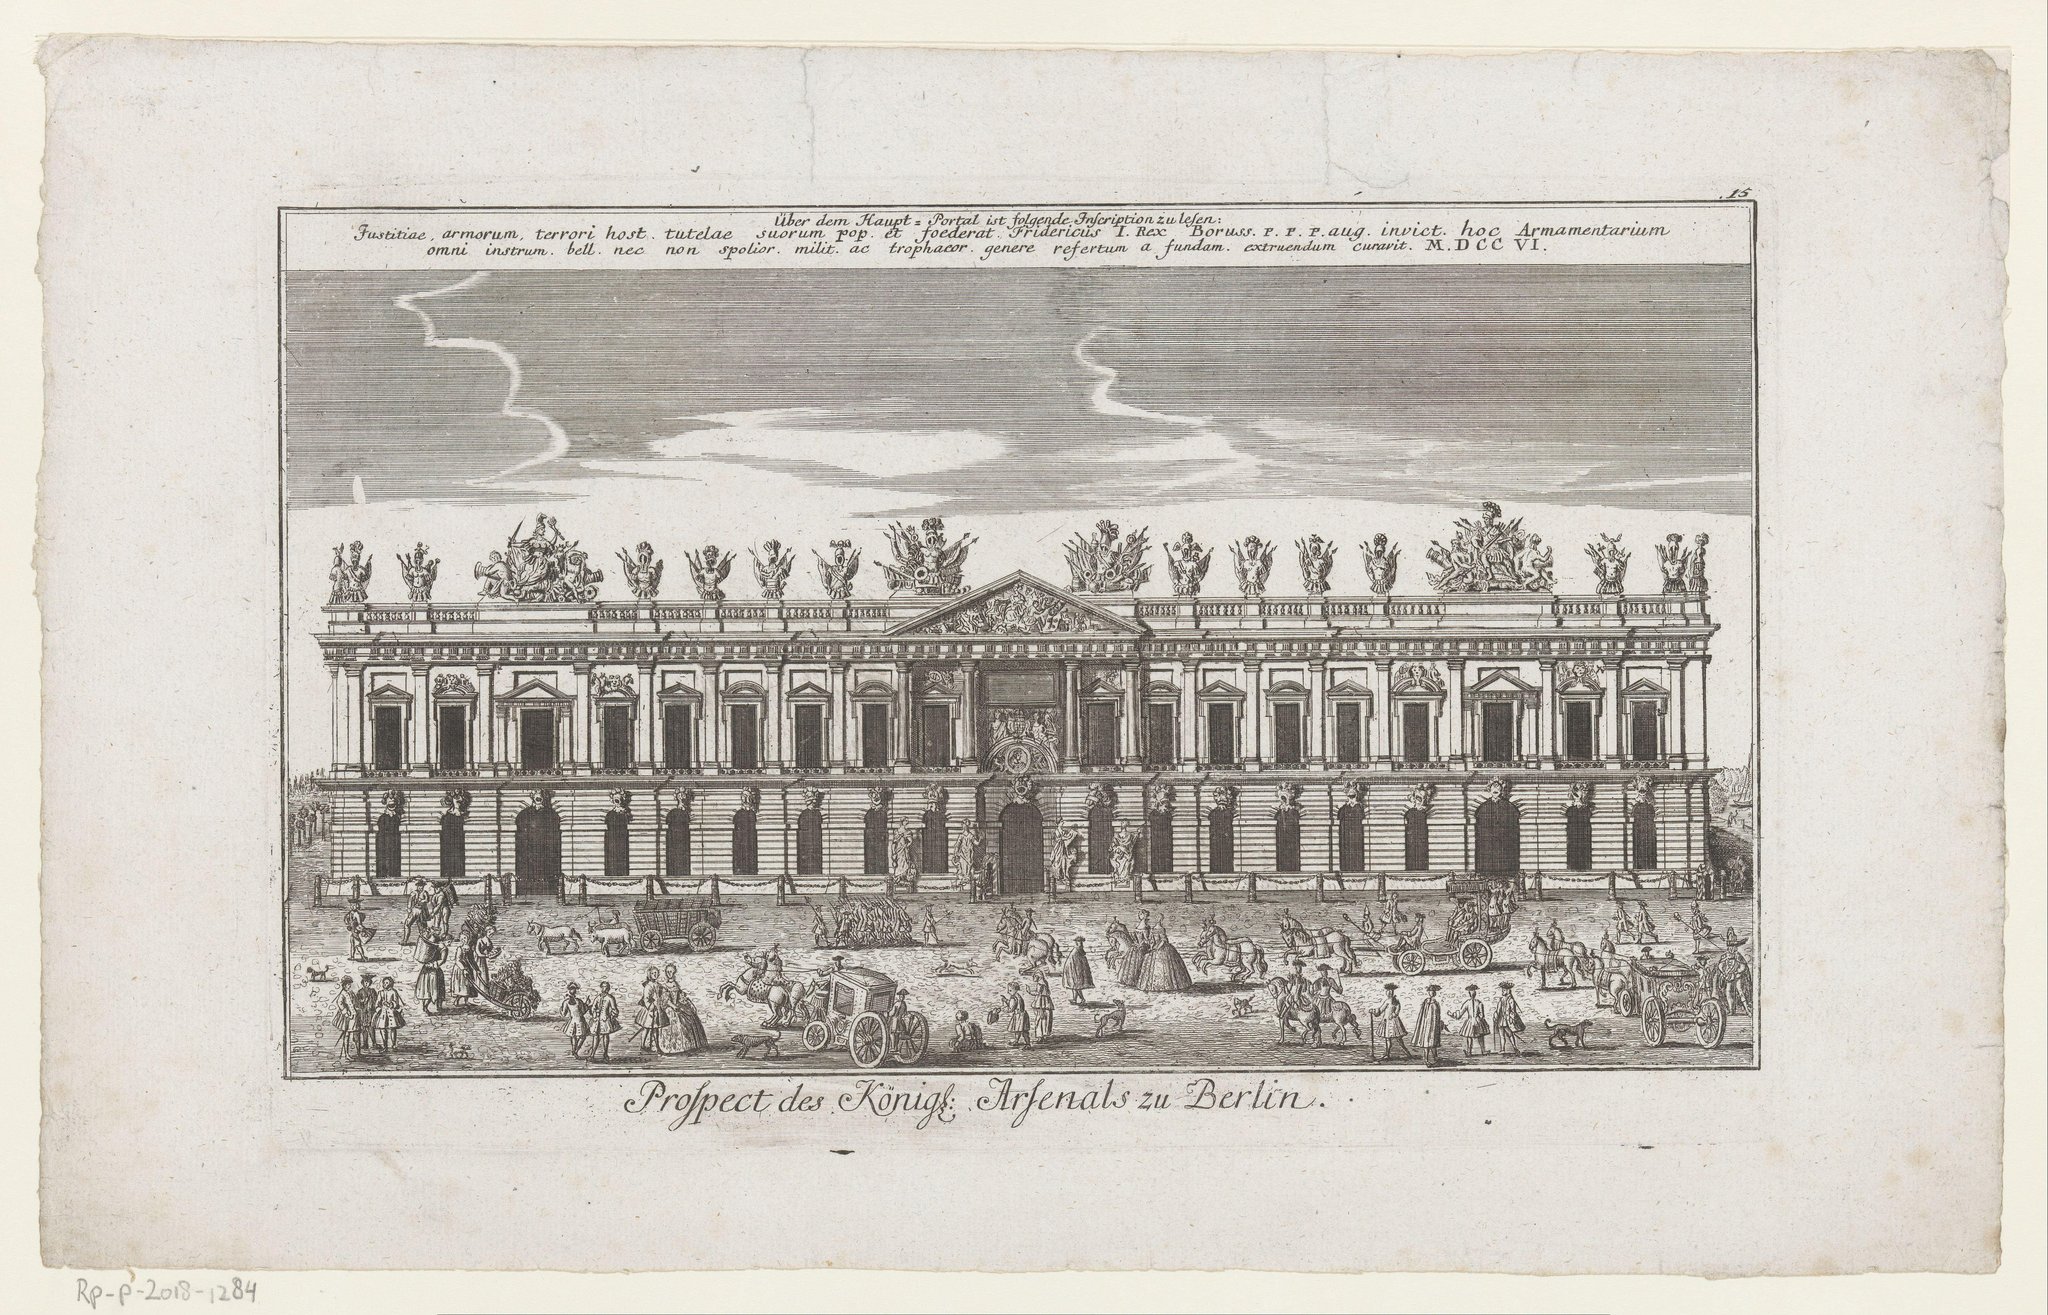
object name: print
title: Gezicht op de voorzijde van het Zeughaus, te Berlijn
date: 1740-1774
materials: paper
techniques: engraving, etching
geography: berlin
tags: ammunition store, arsenal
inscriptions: collector's mark: Lugt 2228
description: Bovenin de prent wordt de inscriptie vermeld die boven de hoofdingang van het gebouw staat. Rechtsboven genummerd: 15.